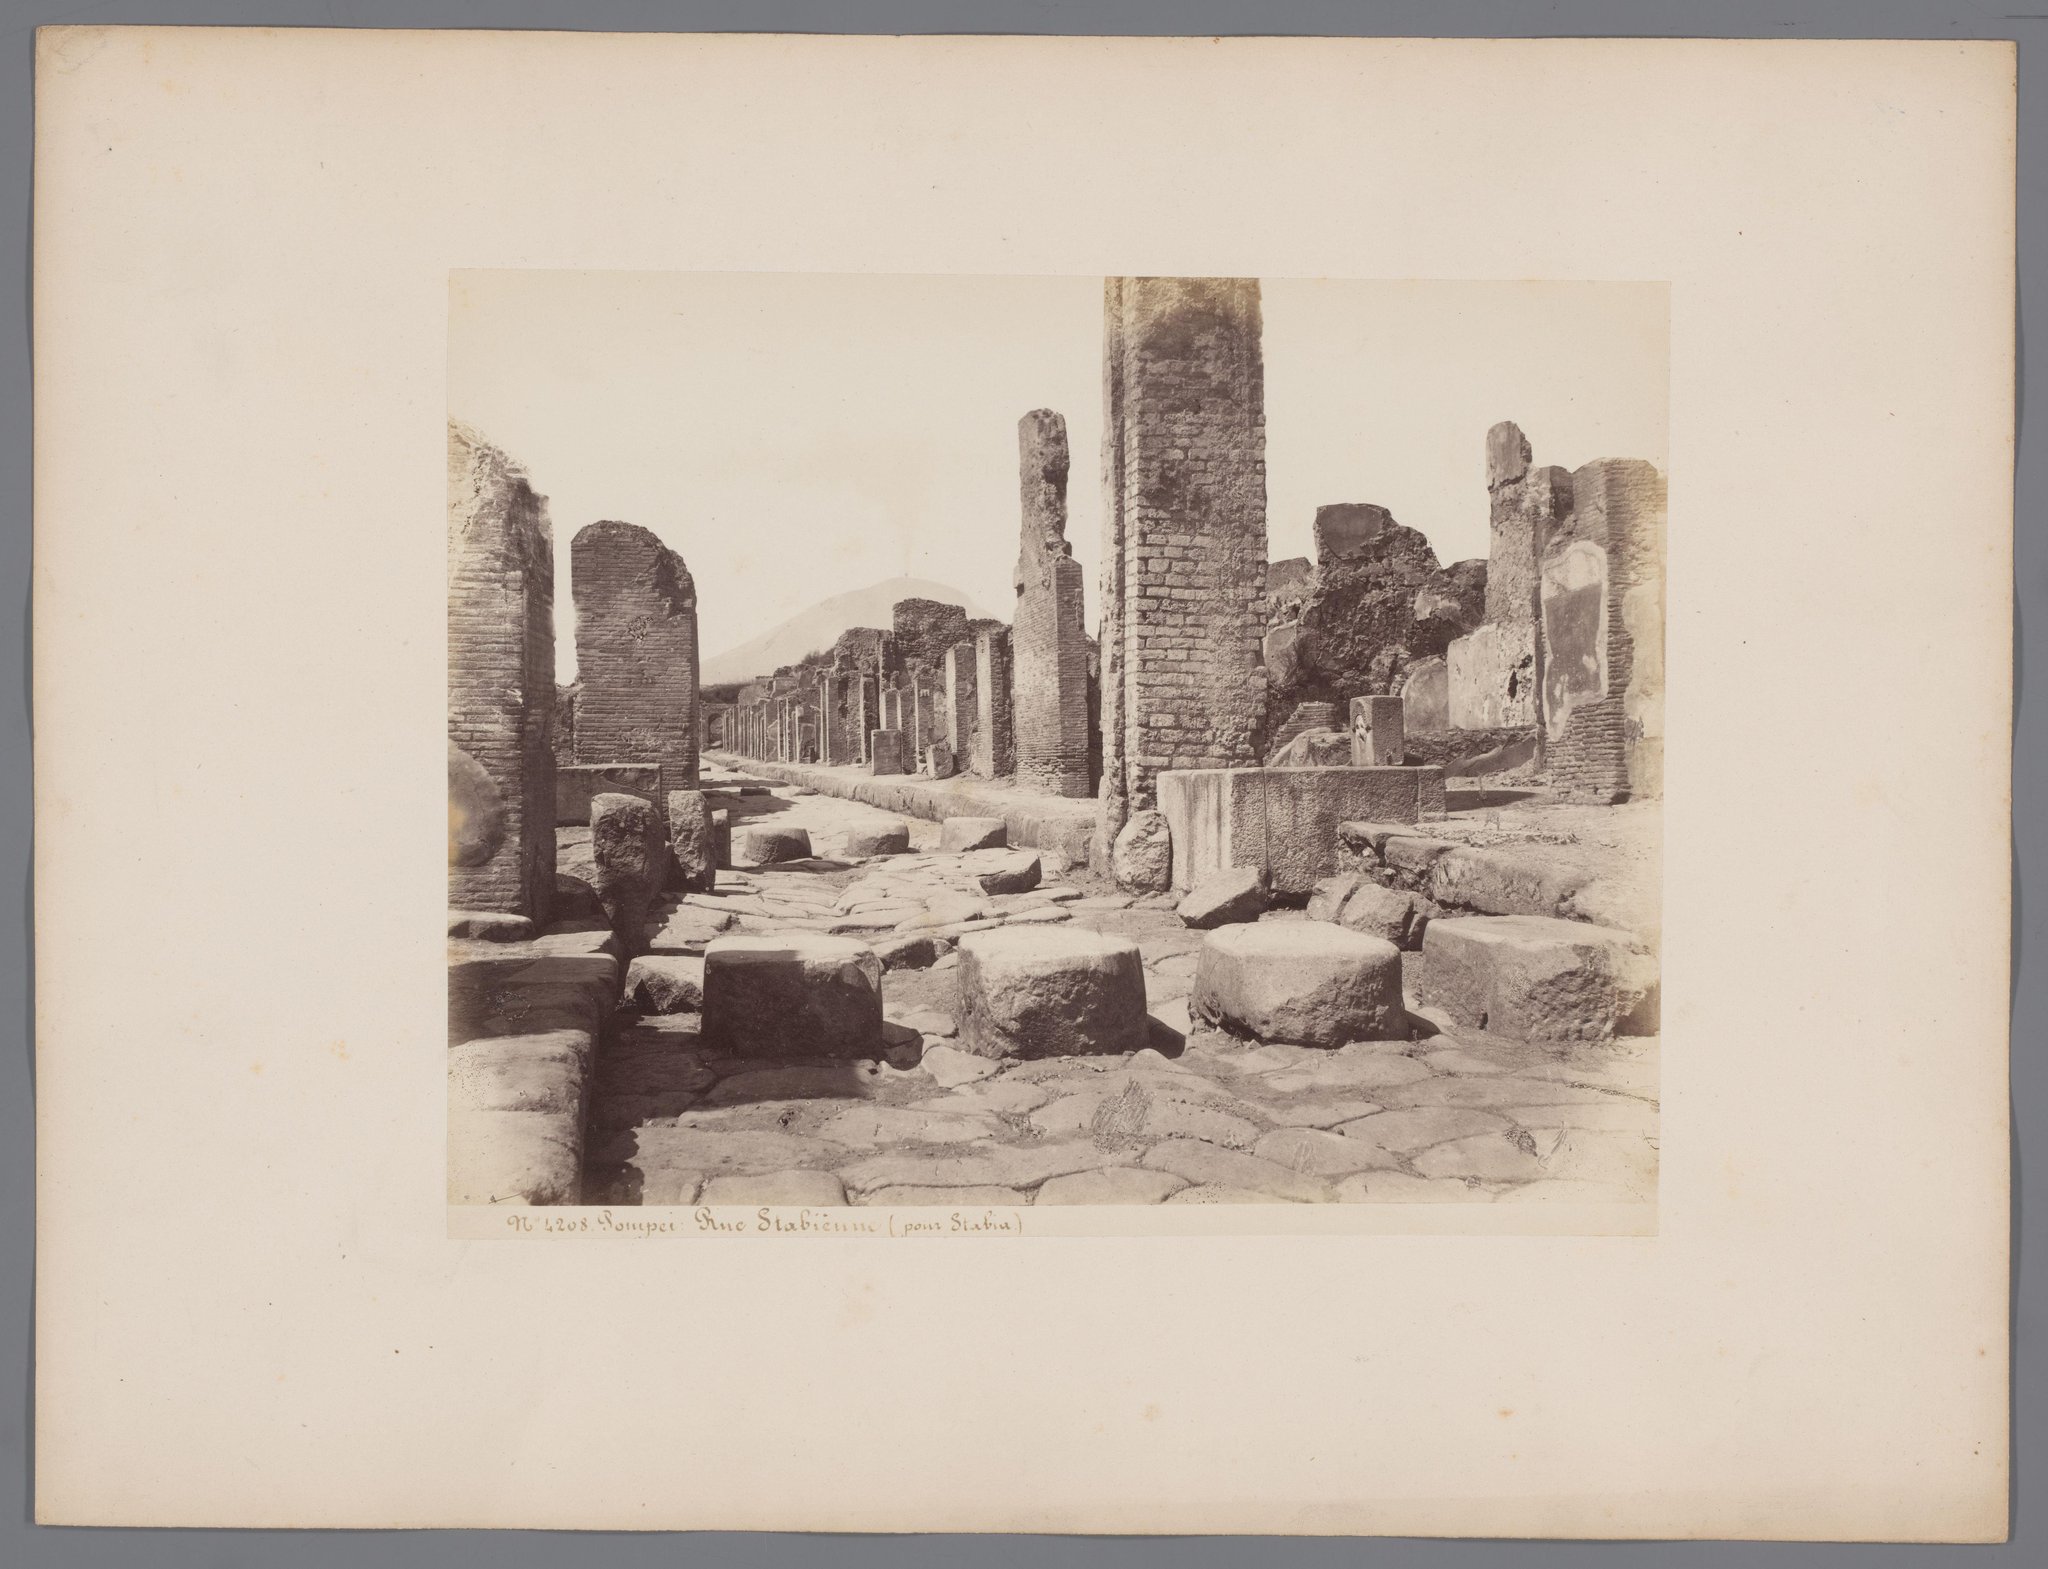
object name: photograph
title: Pompei Rue Stabienne (pour Stabia)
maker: giorgio sommer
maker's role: fotograaf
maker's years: 1834-1914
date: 1857-1914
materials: cardboard, paper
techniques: albumen print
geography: pompeii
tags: landscape with ruins, pompeii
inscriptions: number: ‘10’, inscription: ‘Sommer (t)’, number: ‘No. 4208’